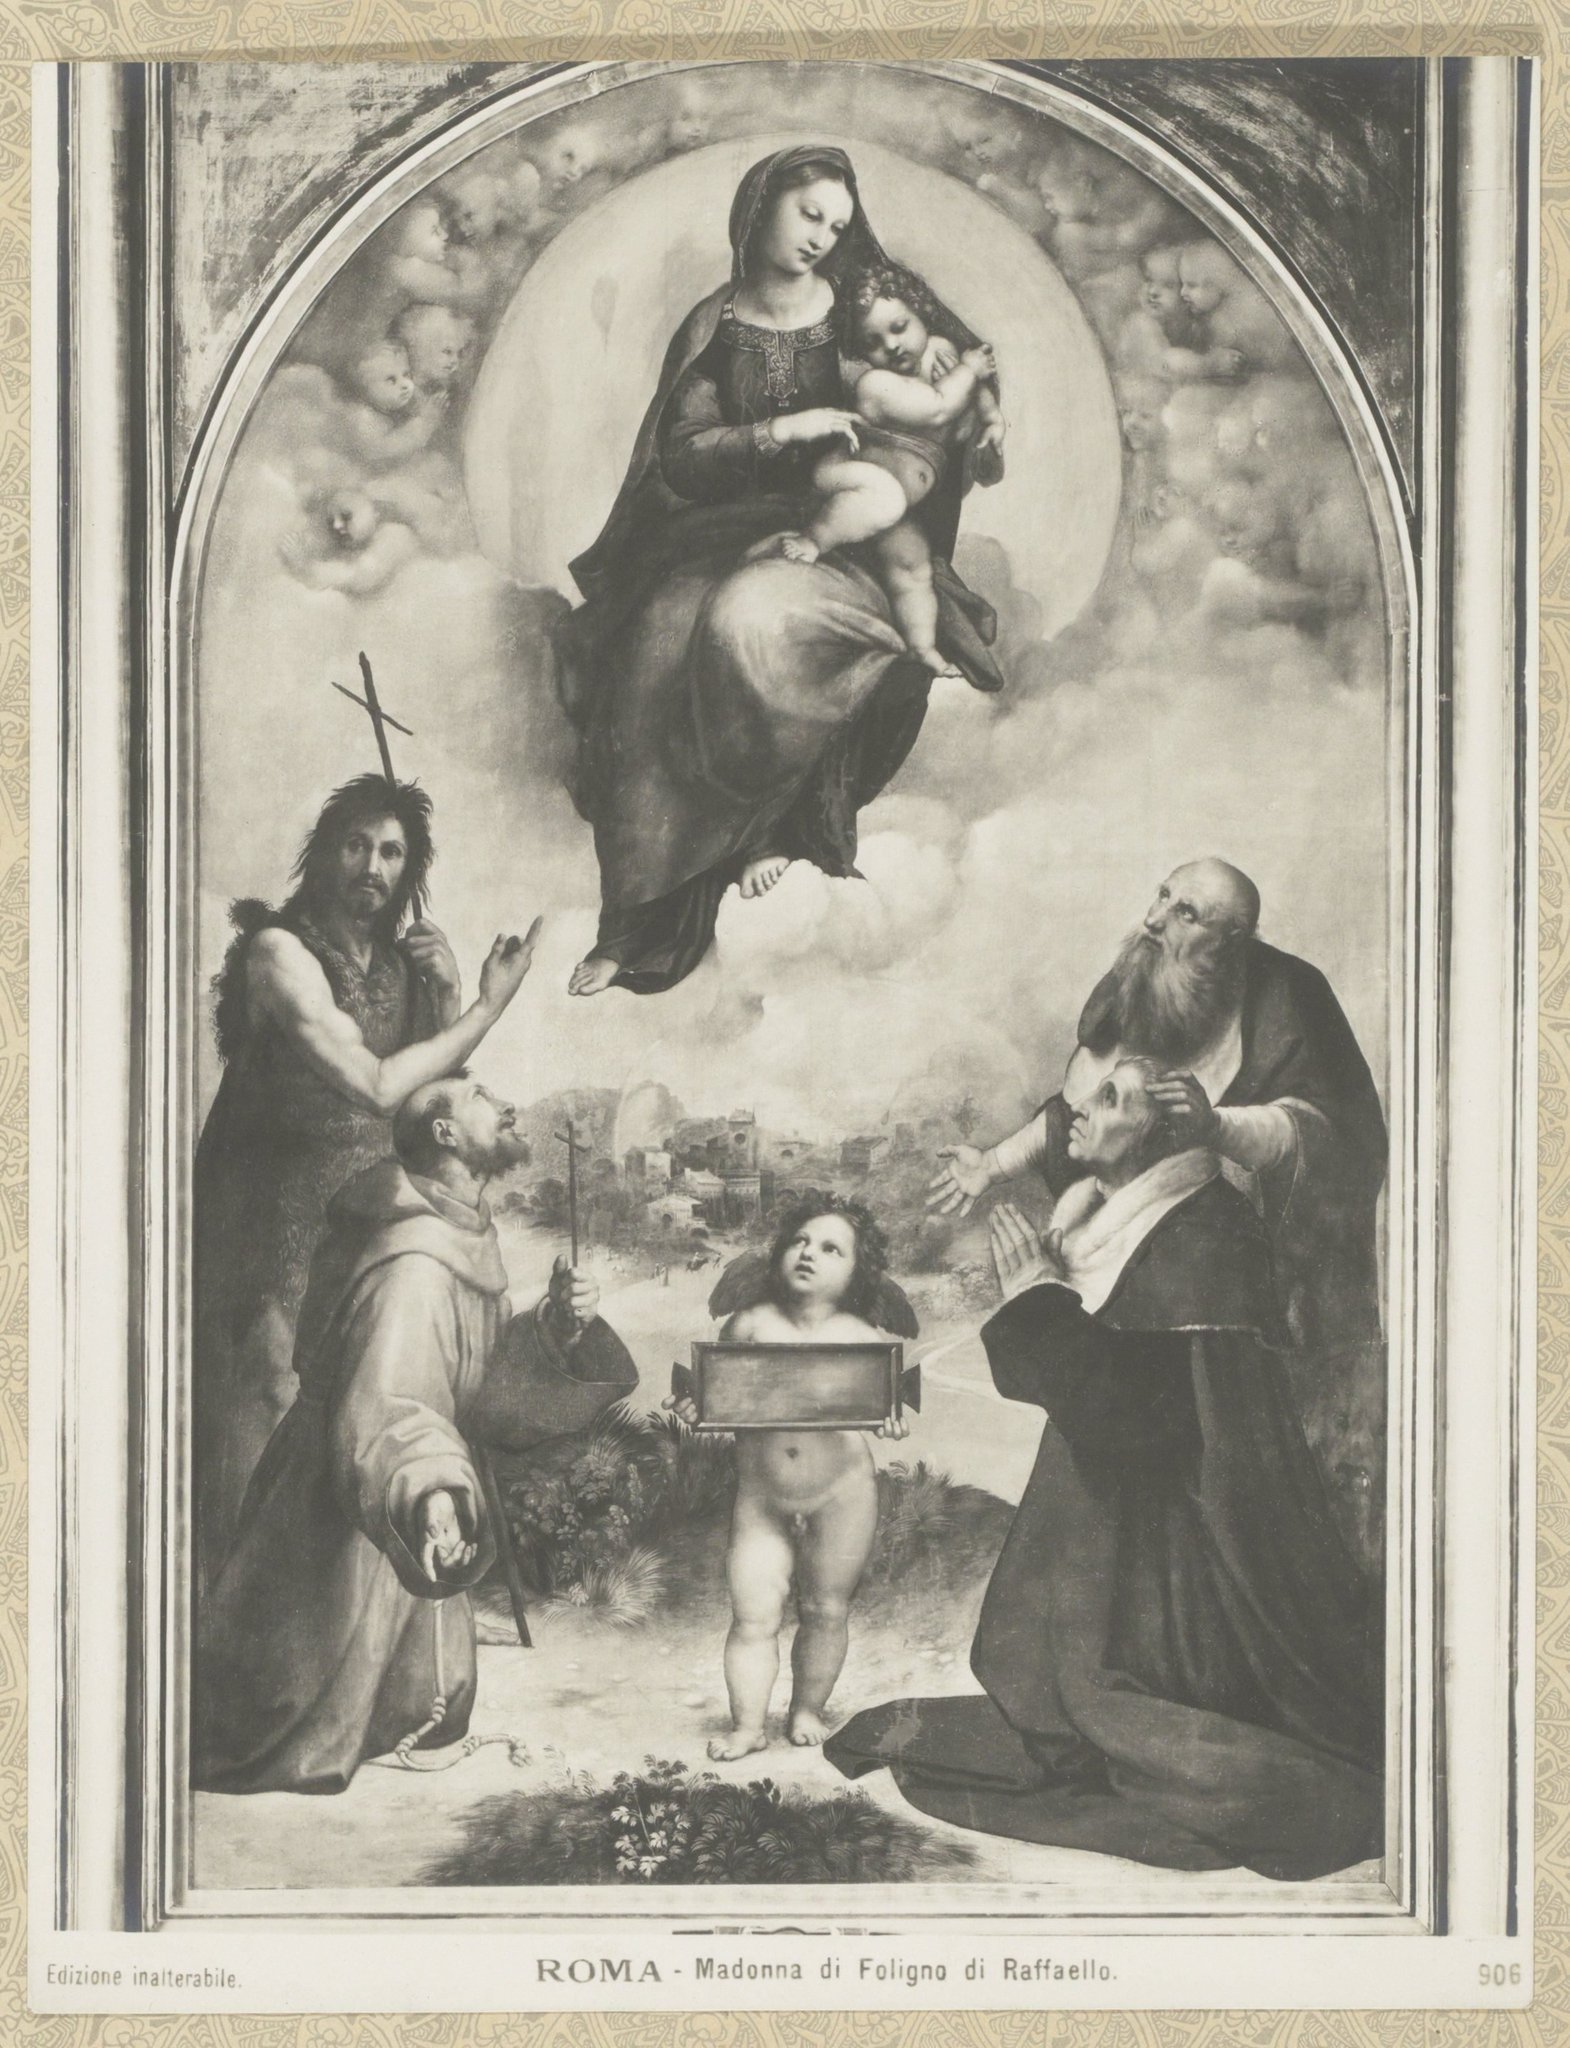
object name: photograph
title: Fotoreproductie van het schilderij De Madonna van Foligno door Rafaël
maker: Anonymous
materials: photographic support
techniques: gelatin silver print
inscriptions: number: ‘906’, inscription: ‘Edizione inalterabile’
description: Onderdeel van Fotoalbum van een reis door Zuid-Europa en het Midden-Oosten.